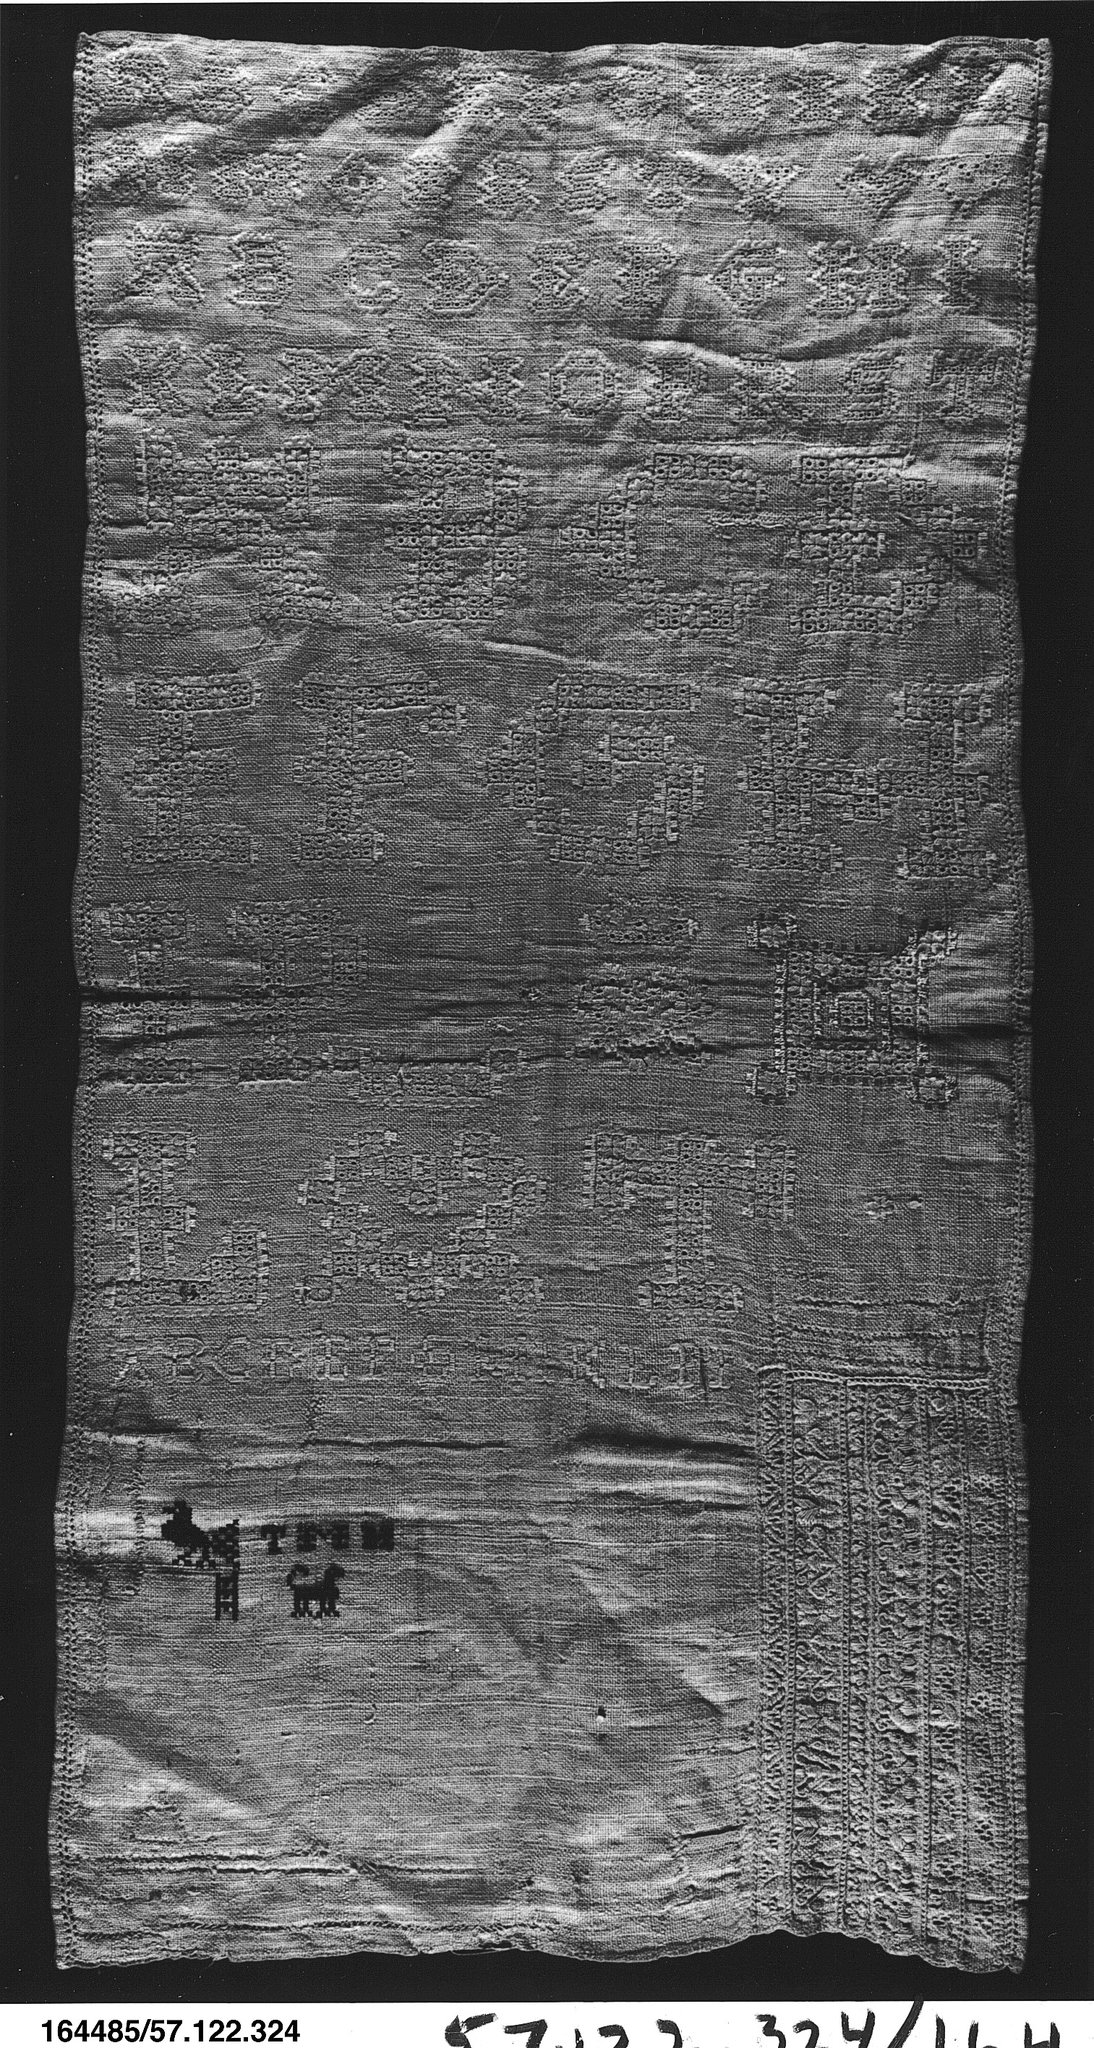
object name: sampler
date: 1701-1800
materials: linen, silk